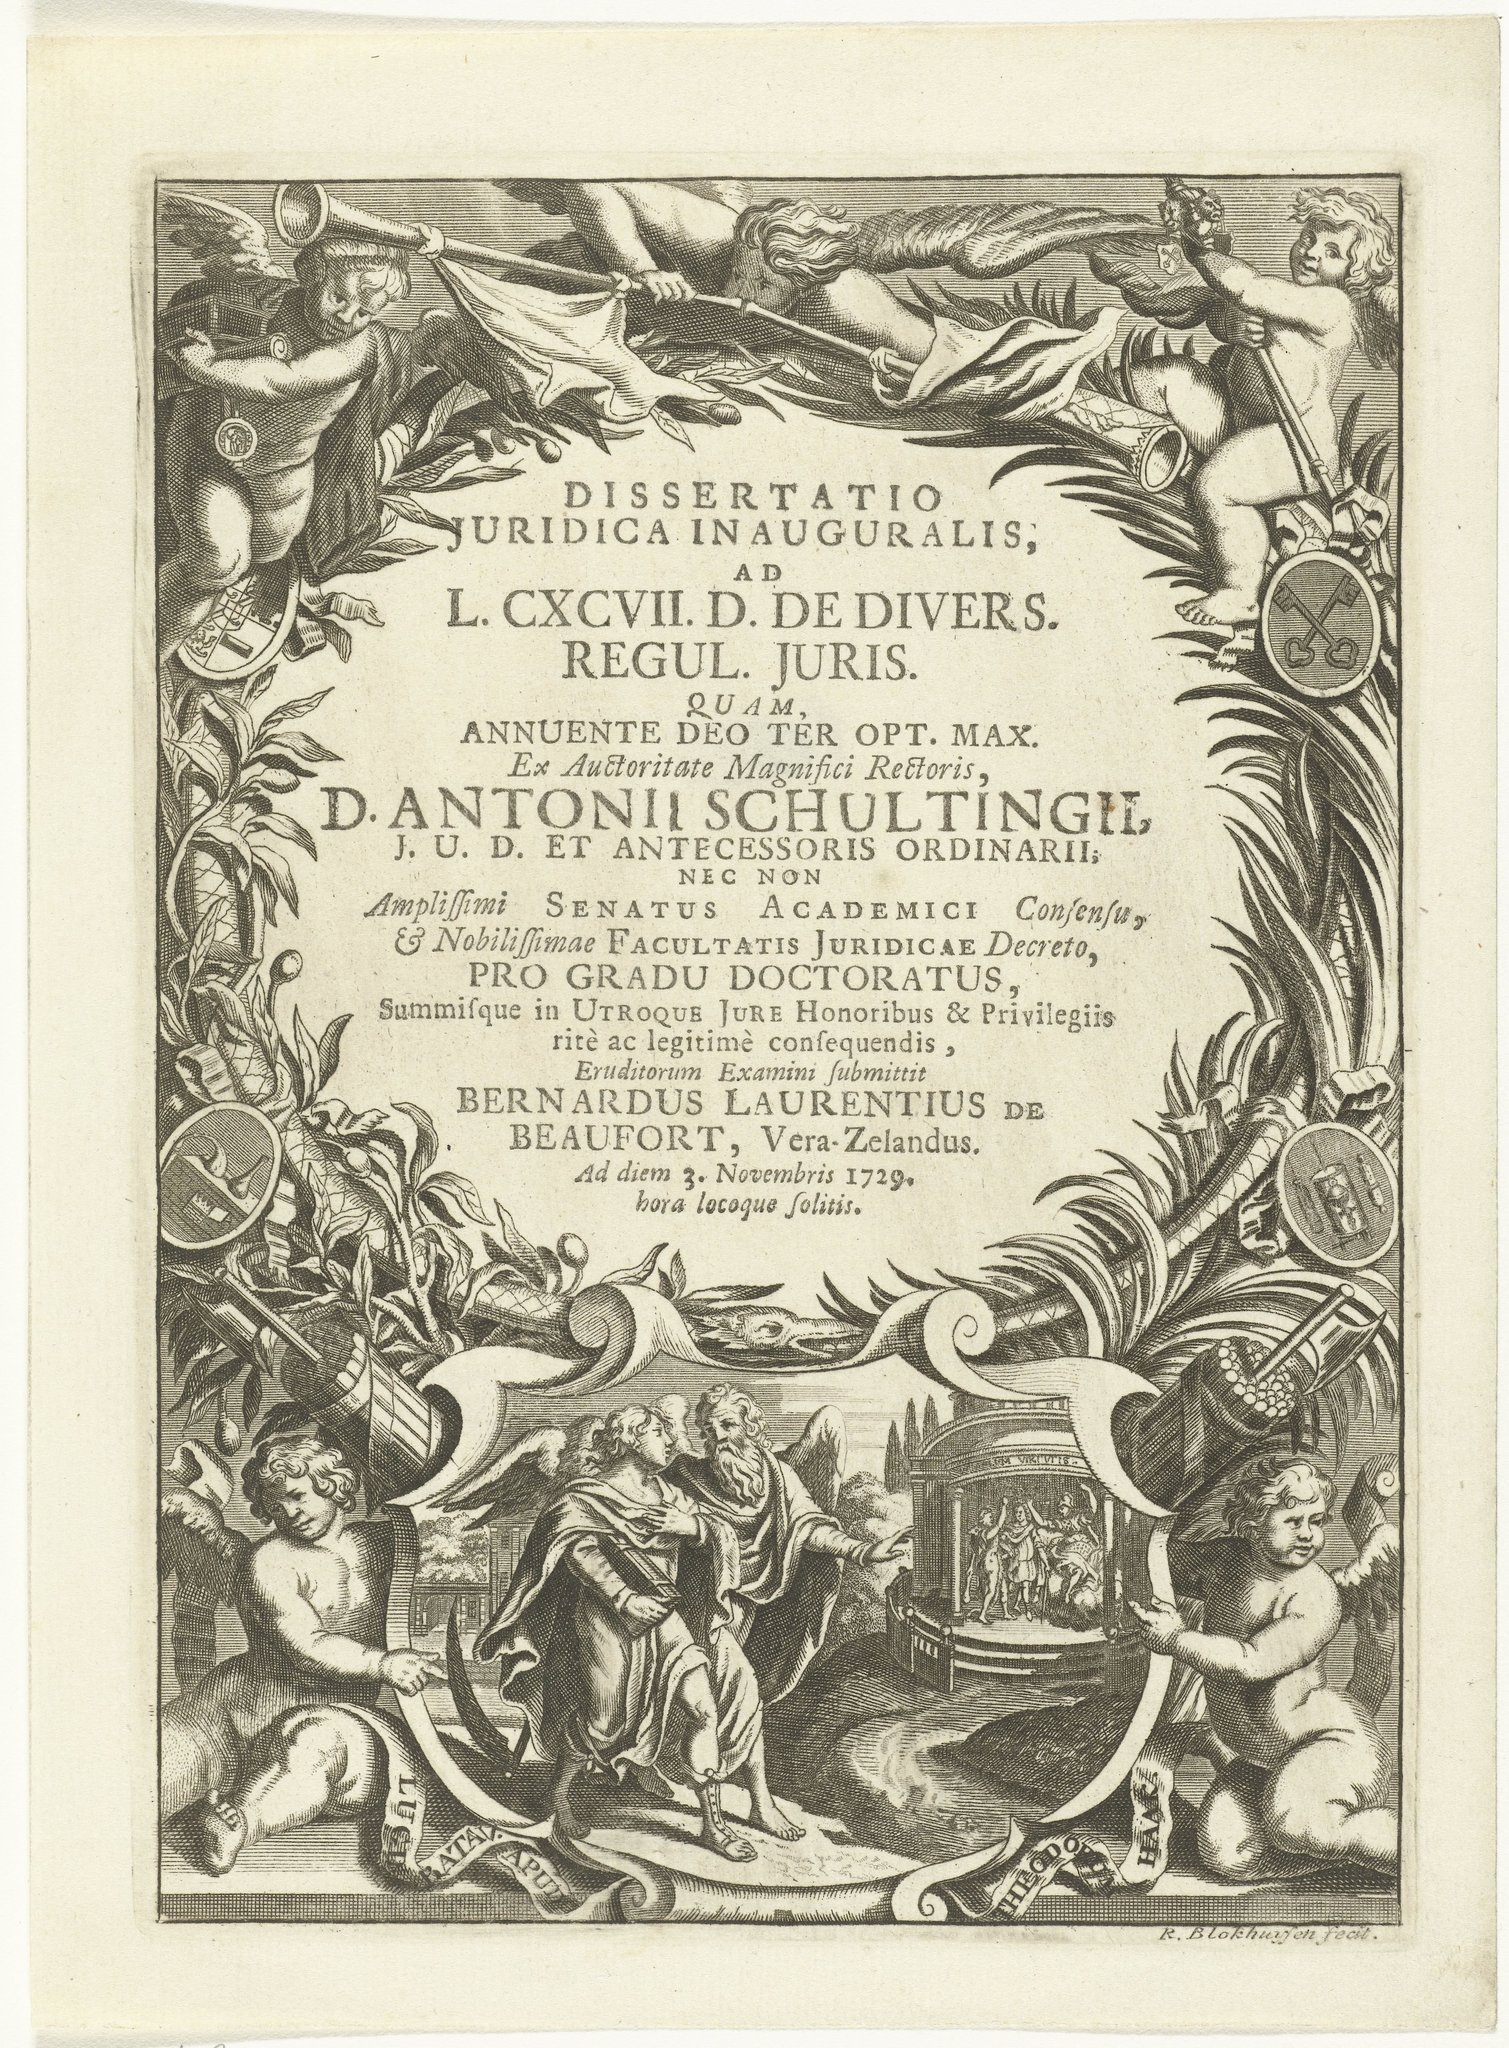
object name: print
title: Titelpagina voor: Antonius Schultingius, Dissertatio juridica inauguralis ad L CXCVII D de divers regul juris quam annuente deo ter opt. max, Leiden 1729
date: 1729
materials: paper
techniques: etching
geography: leiden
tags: fame; 'fama', 'fama buona', 'fama chiara' (ripa), father time, man with wings and scythe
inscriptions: collector's mark: Lugt 2228, collector's mark: Lugt 2760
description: Allegorie op de wetenschap met personificatie van roem die op twee loftrompetten blaast en een tableaux met deTijd die een man of vrouw met boek naar een tempel met deugden leidt.